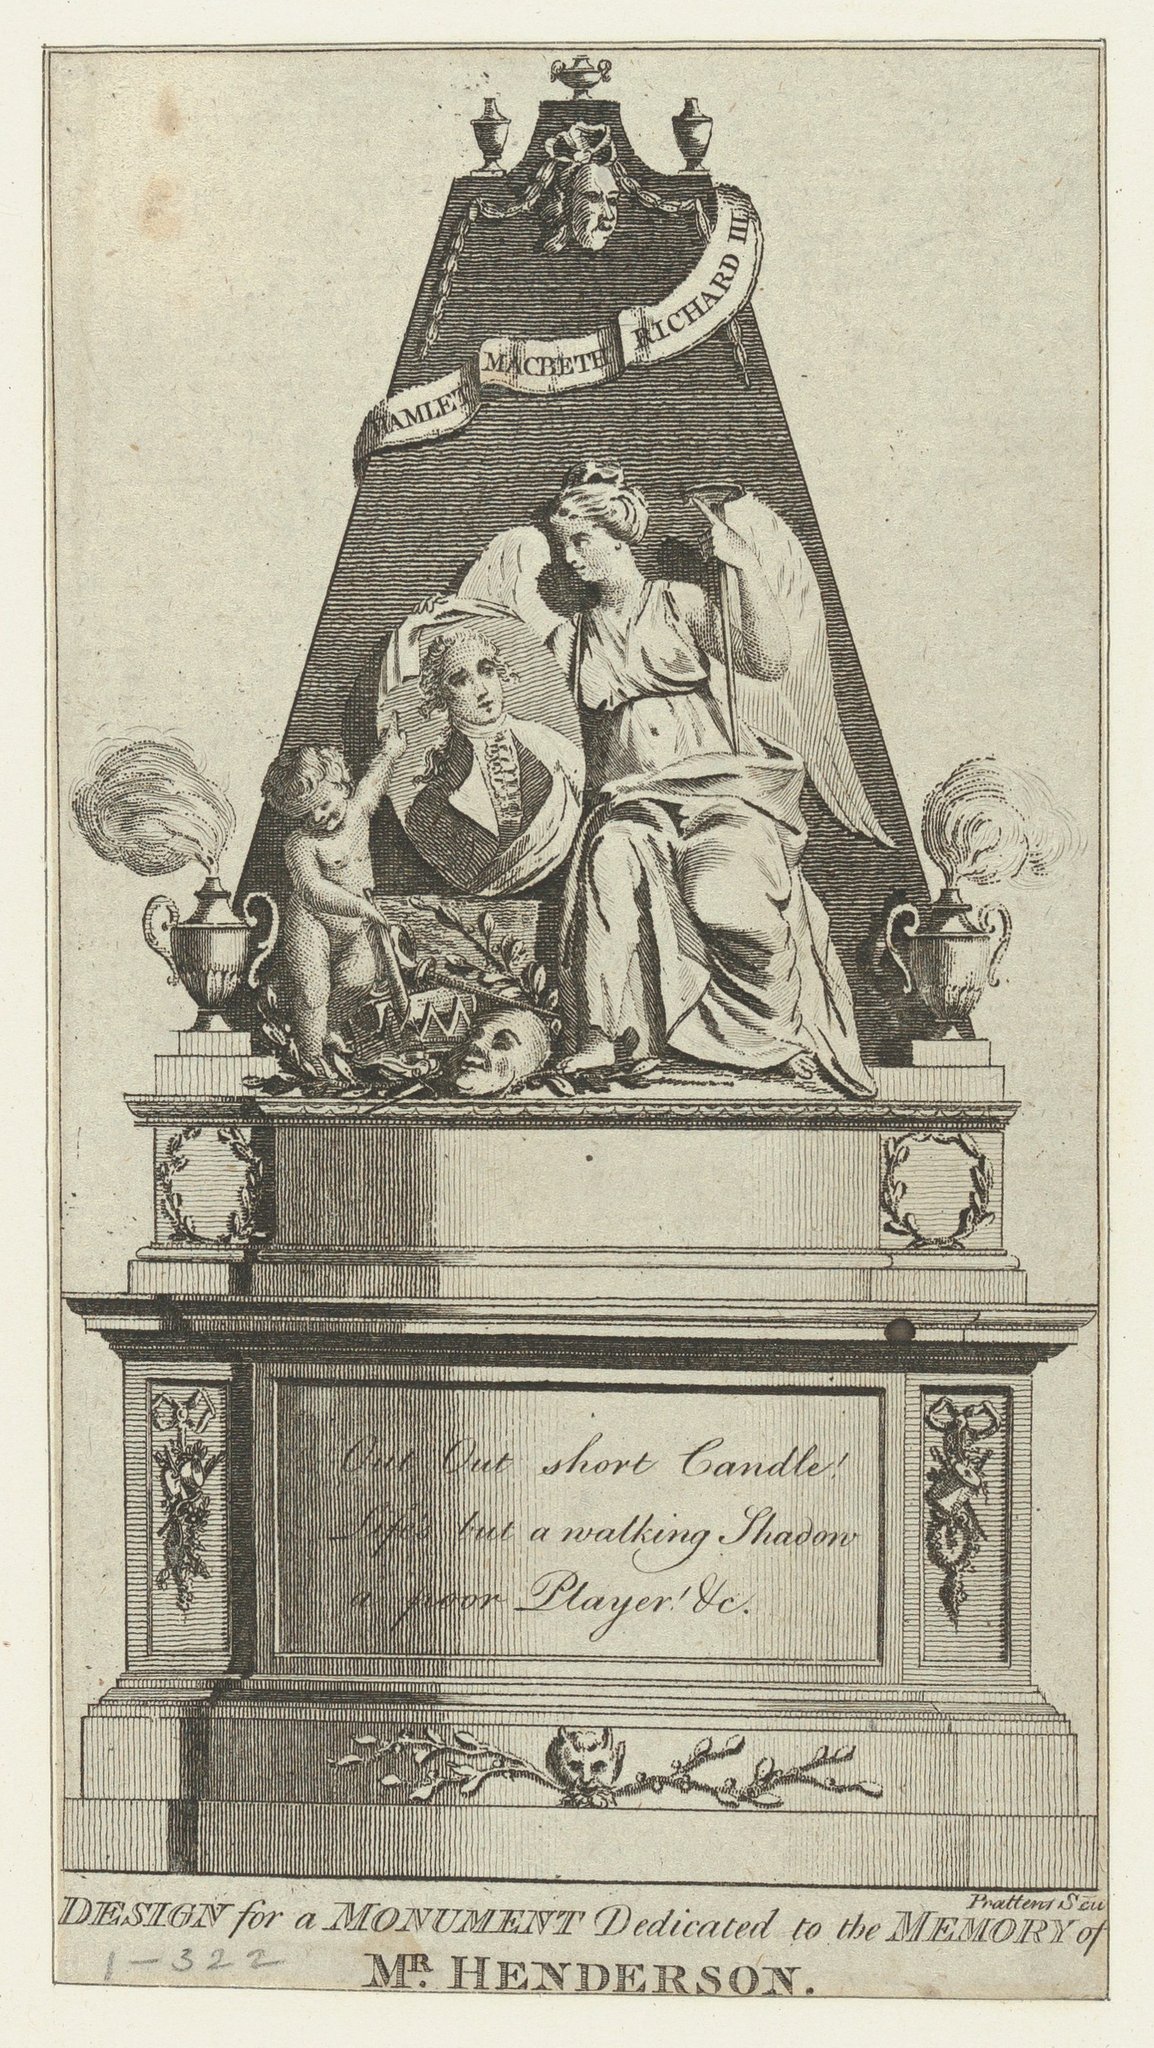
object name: print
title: A Design for a Monument Dedicated to the Memory of Mr. Henderson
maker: thomas prattent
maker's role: engraver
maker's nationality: british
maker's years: 1780-1810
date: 1786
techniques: engraving, etching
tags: monuments,men,women,putti